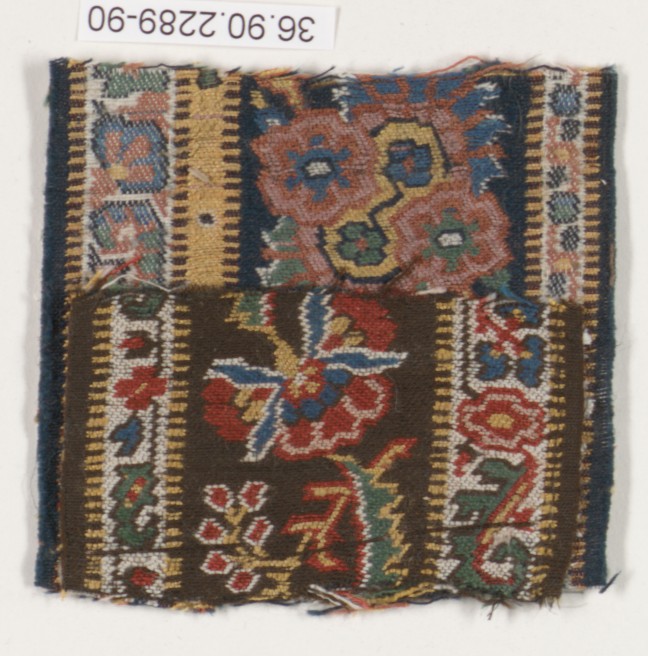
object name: border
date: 1801-1900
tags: flowers